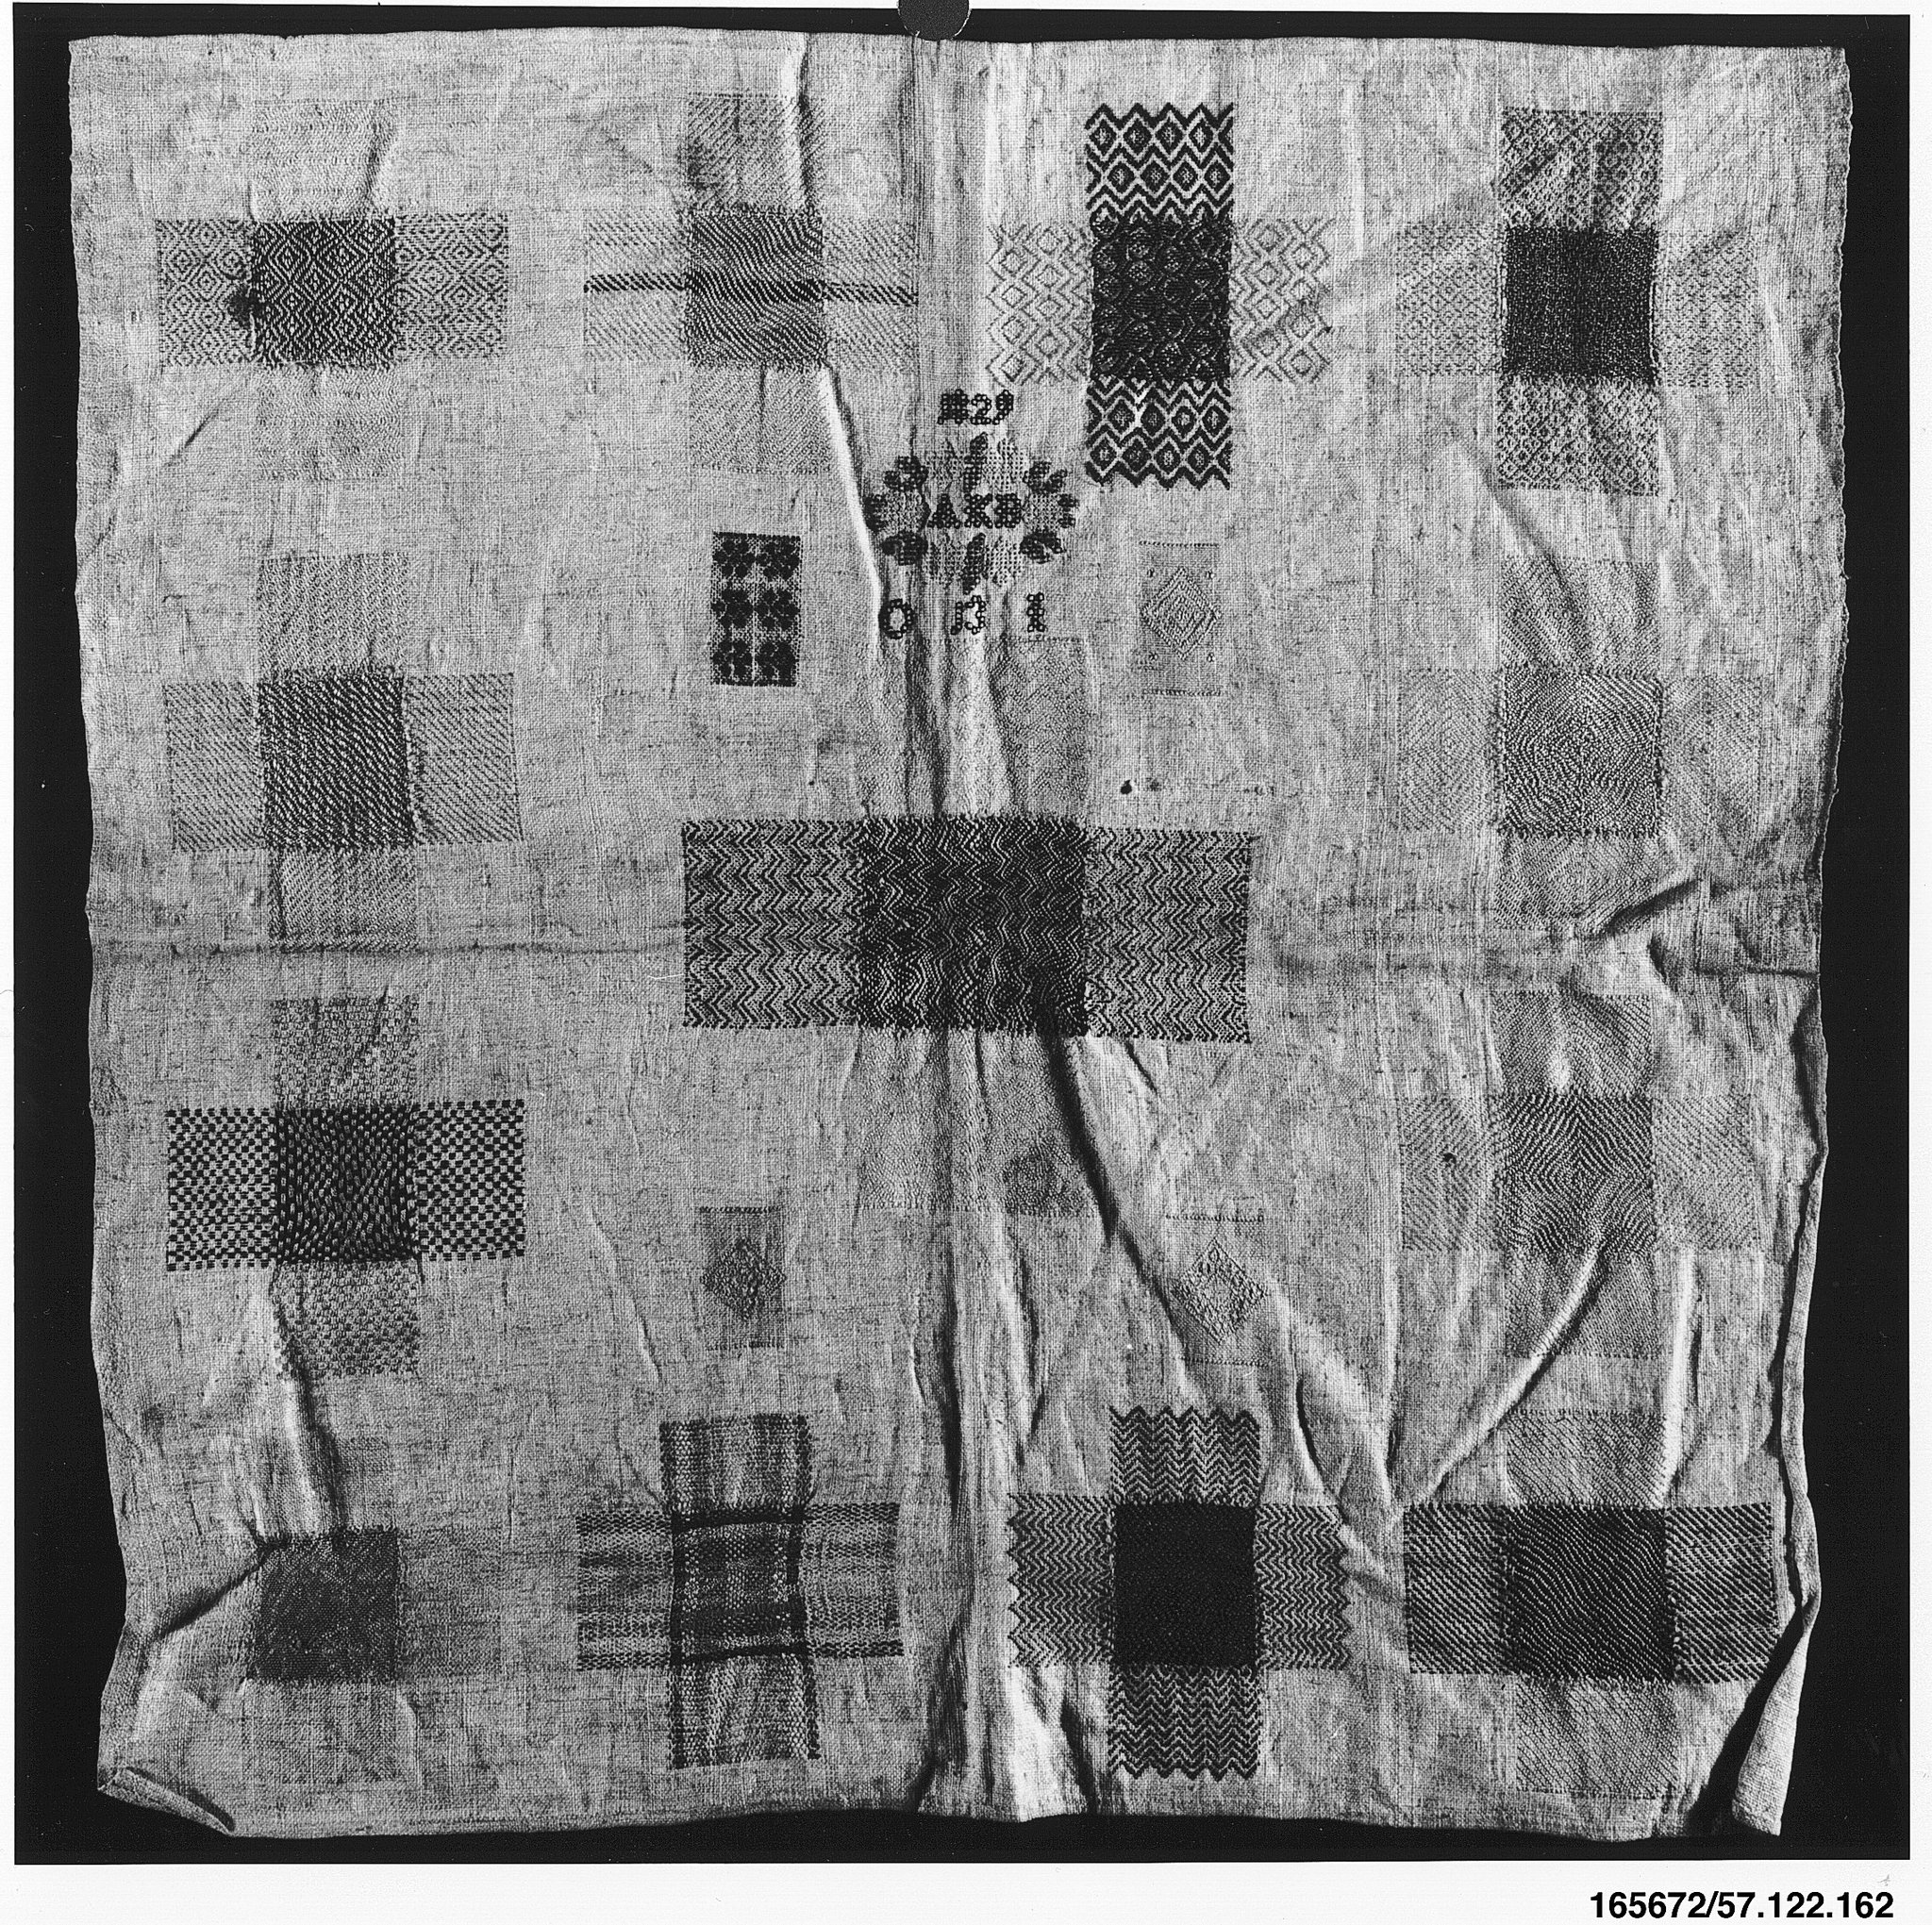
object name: sampler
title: Embroidered darning sampler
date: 1829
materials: linen, silk